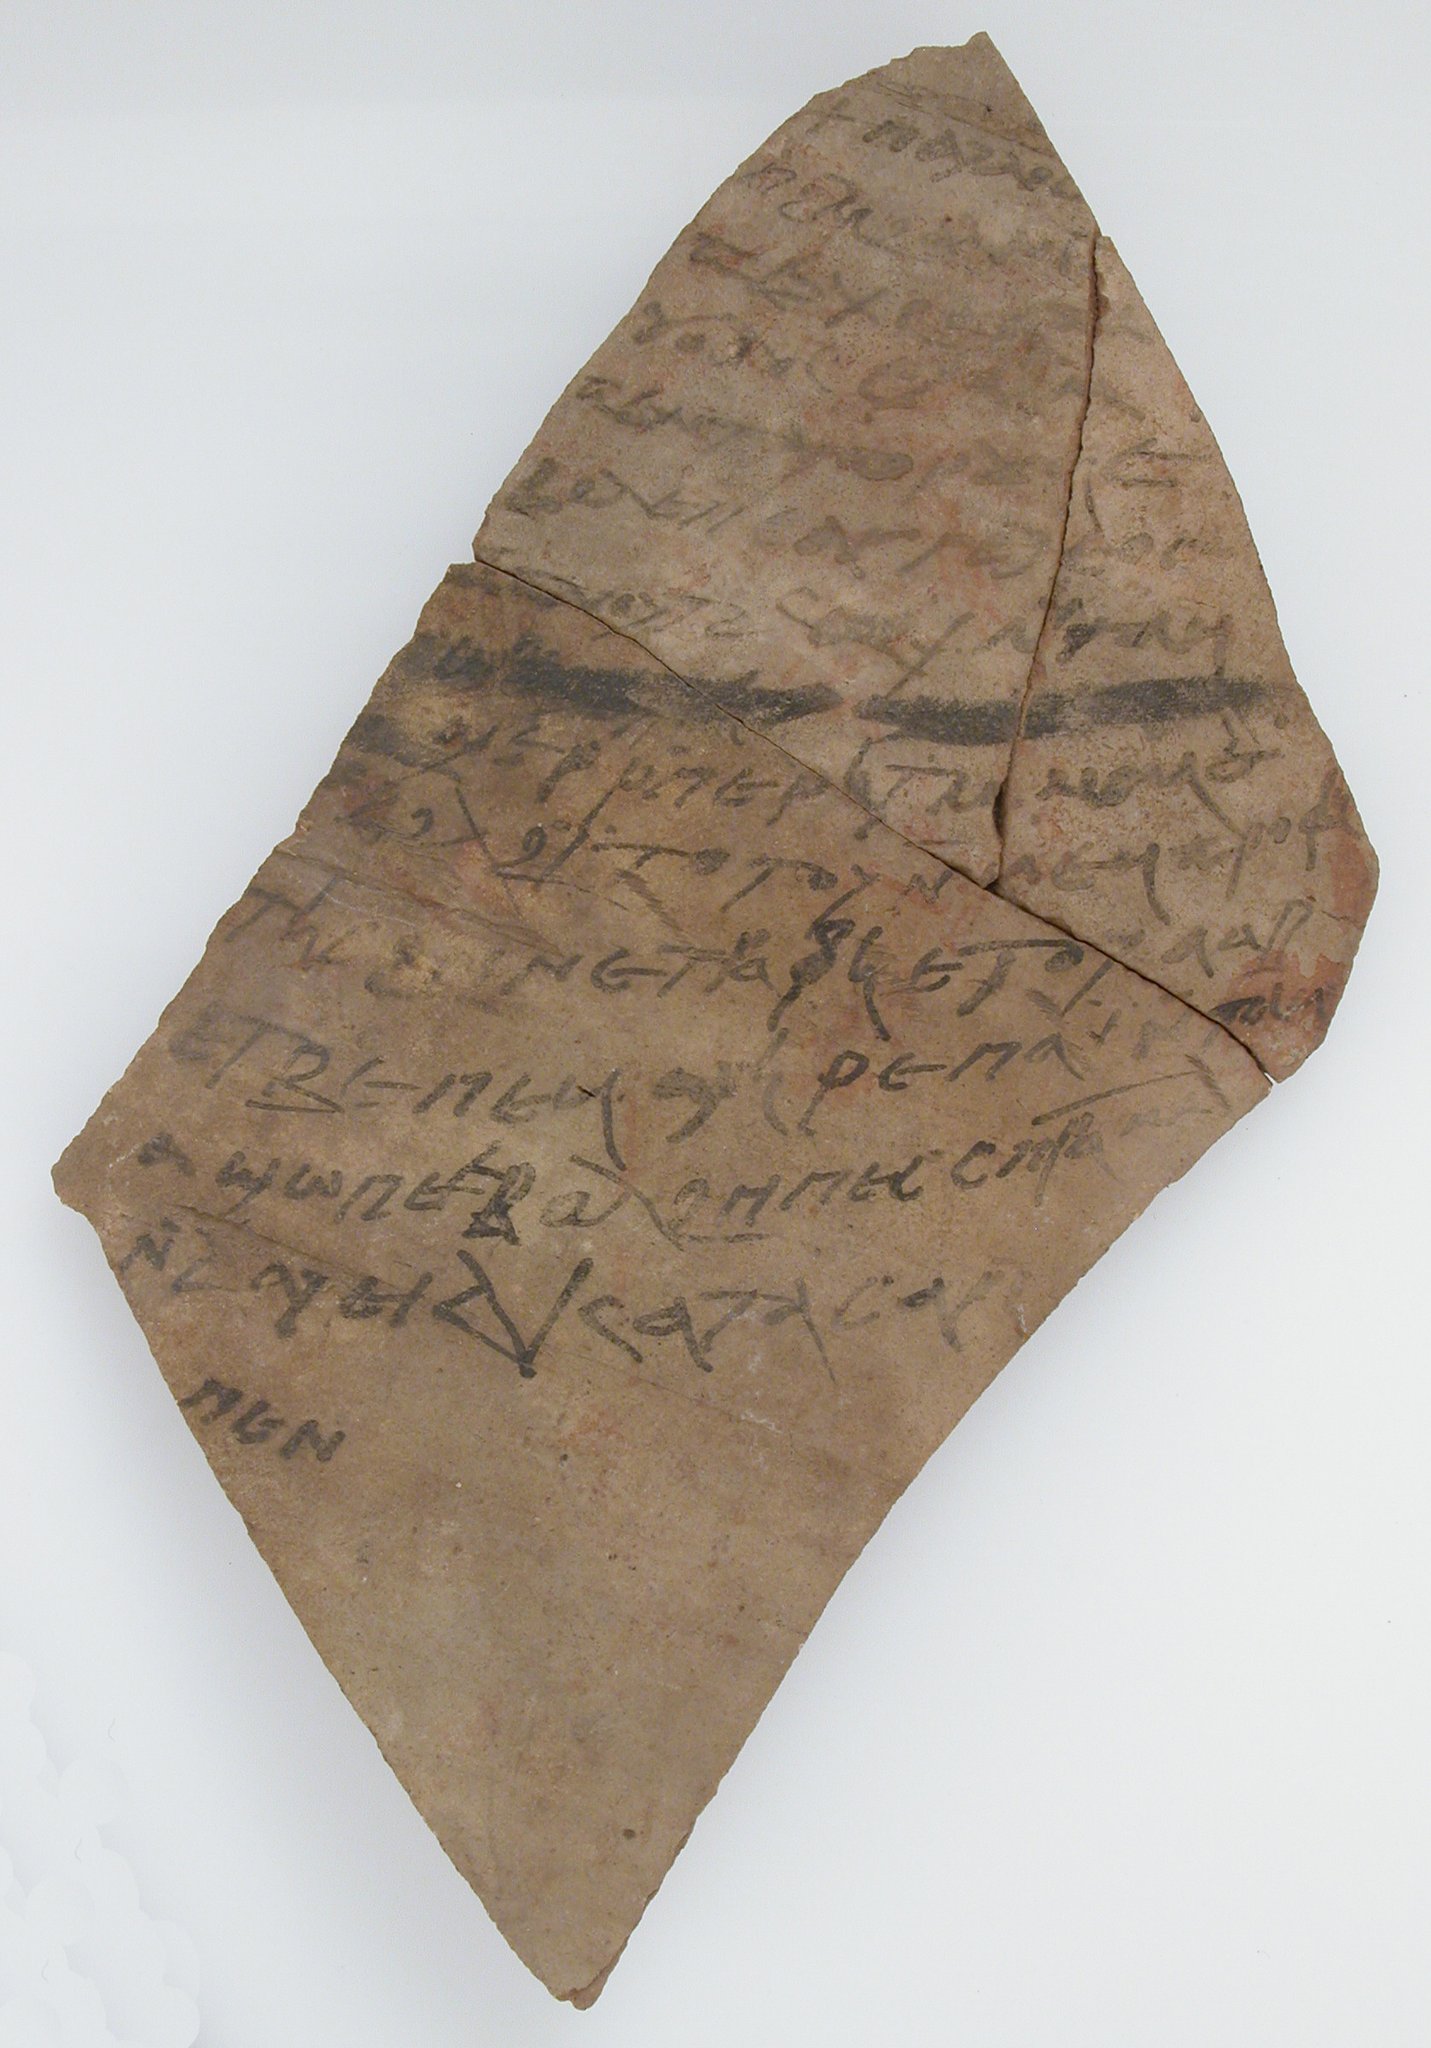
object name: ostrakon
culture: coptic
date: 601-700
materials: ink, pottery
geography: egypt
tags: documents